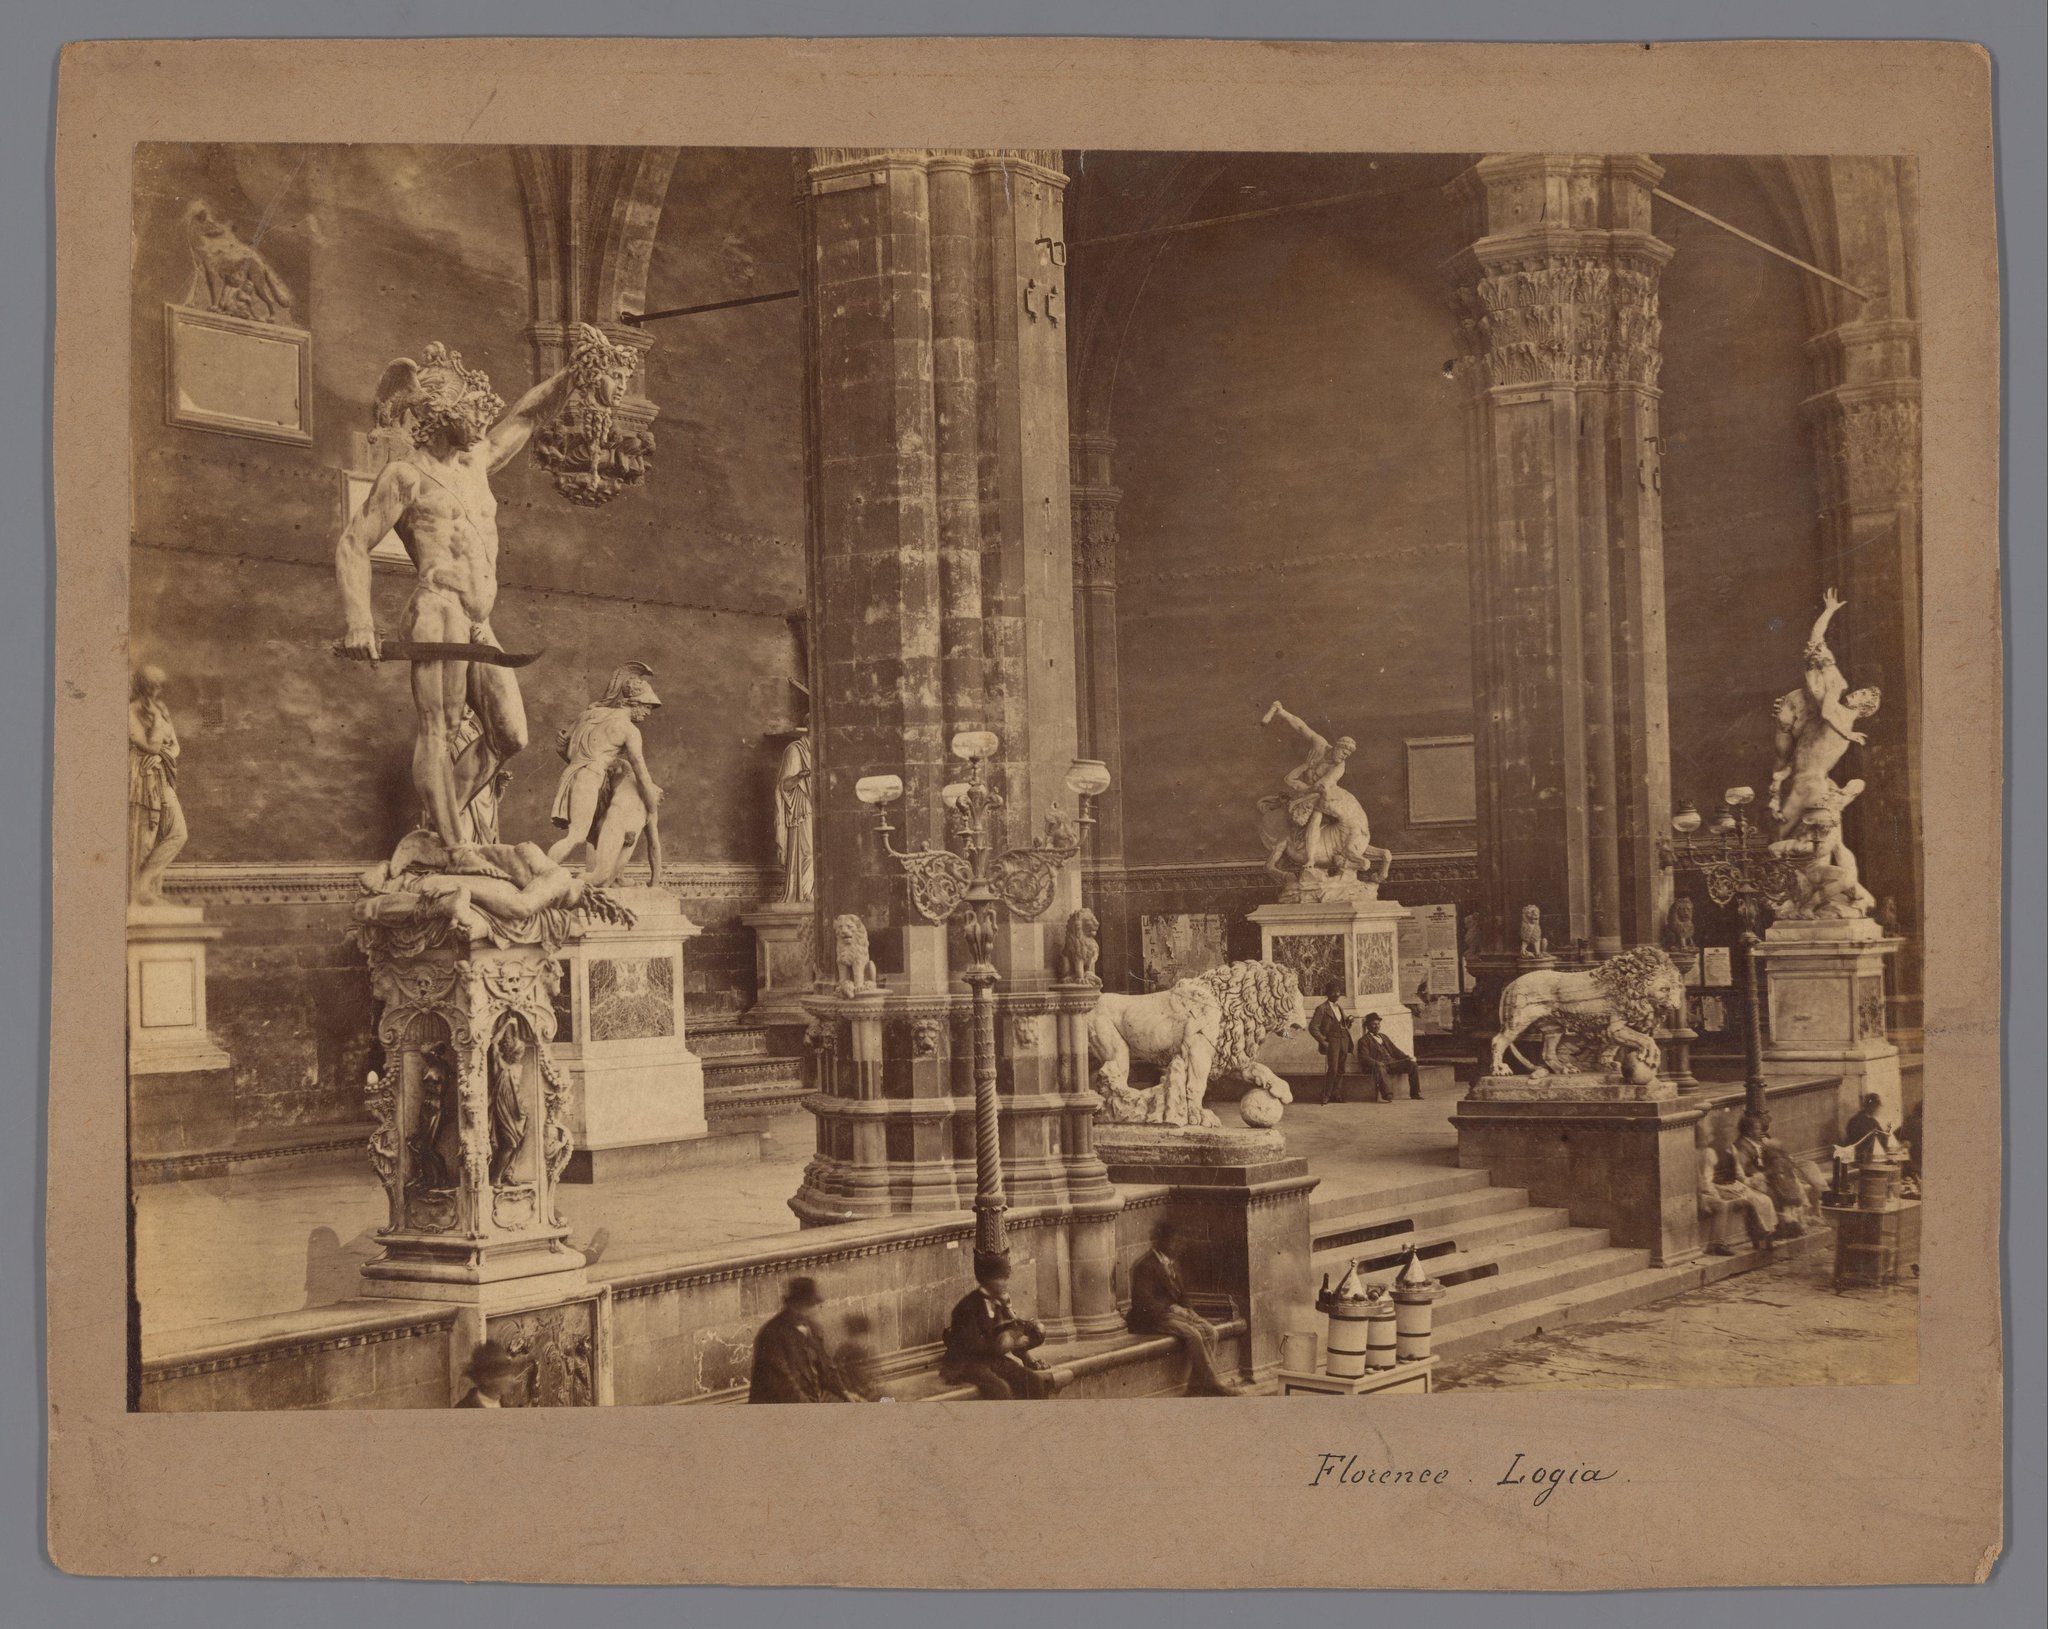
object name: photograph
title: Florence - Logia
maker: Anonymous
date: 1851-1900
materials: cardboard, paper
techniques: albumen print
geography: florence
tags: gallery of sculptures, loggia, verandah, porch